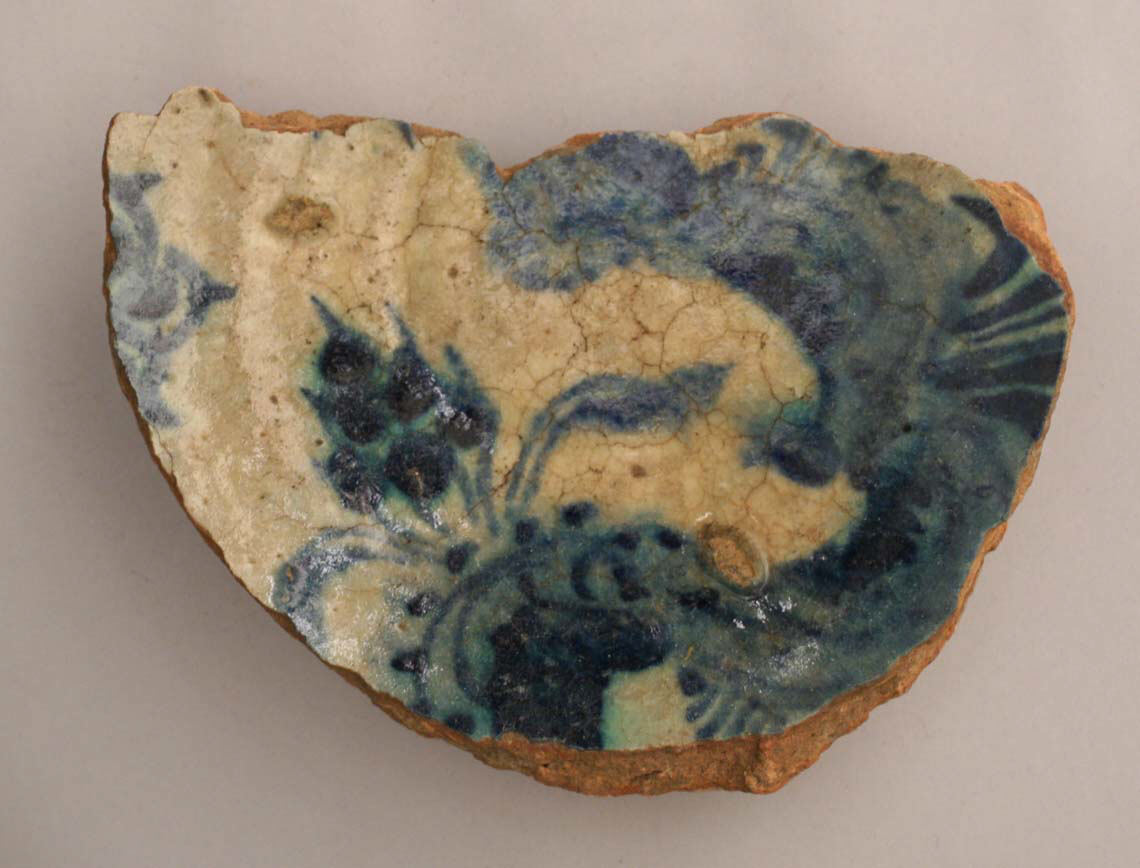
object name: fragment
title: Fragment of a Bowl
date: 1301-1500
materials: glaze, stonepaste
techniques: painting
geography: egypt